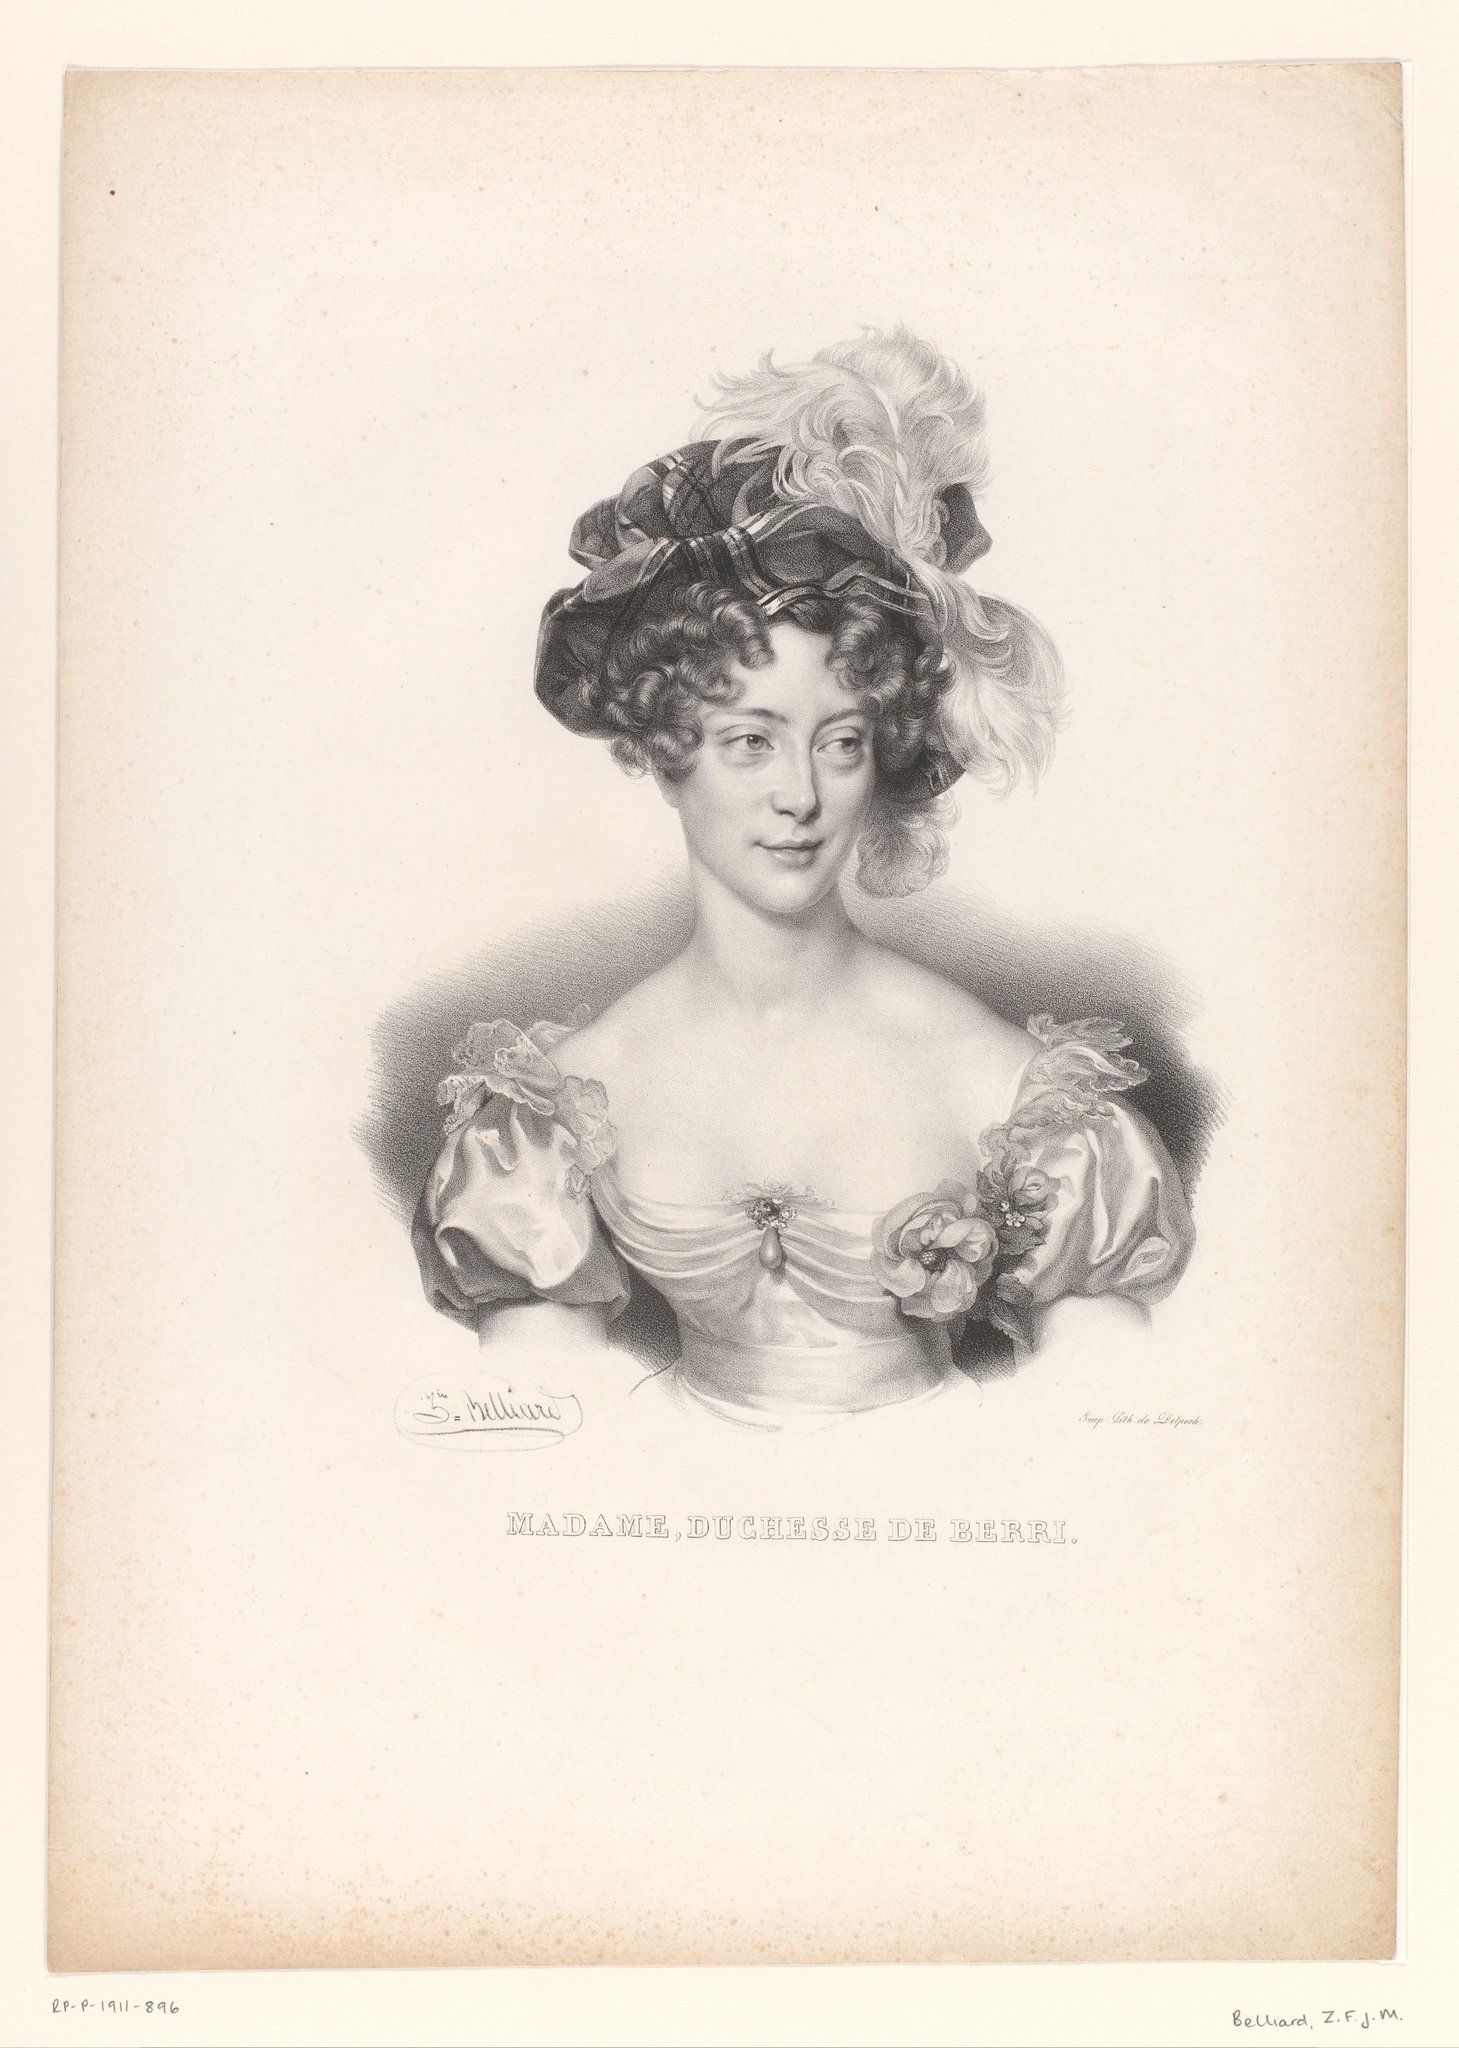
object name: print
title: Portretten van 1789 tot 1829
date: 1829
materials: paper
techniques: lithograph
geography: paris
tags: maria carolina van bourbon-sicilië, historical persons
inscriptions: collector's mark: Lugt 2228a